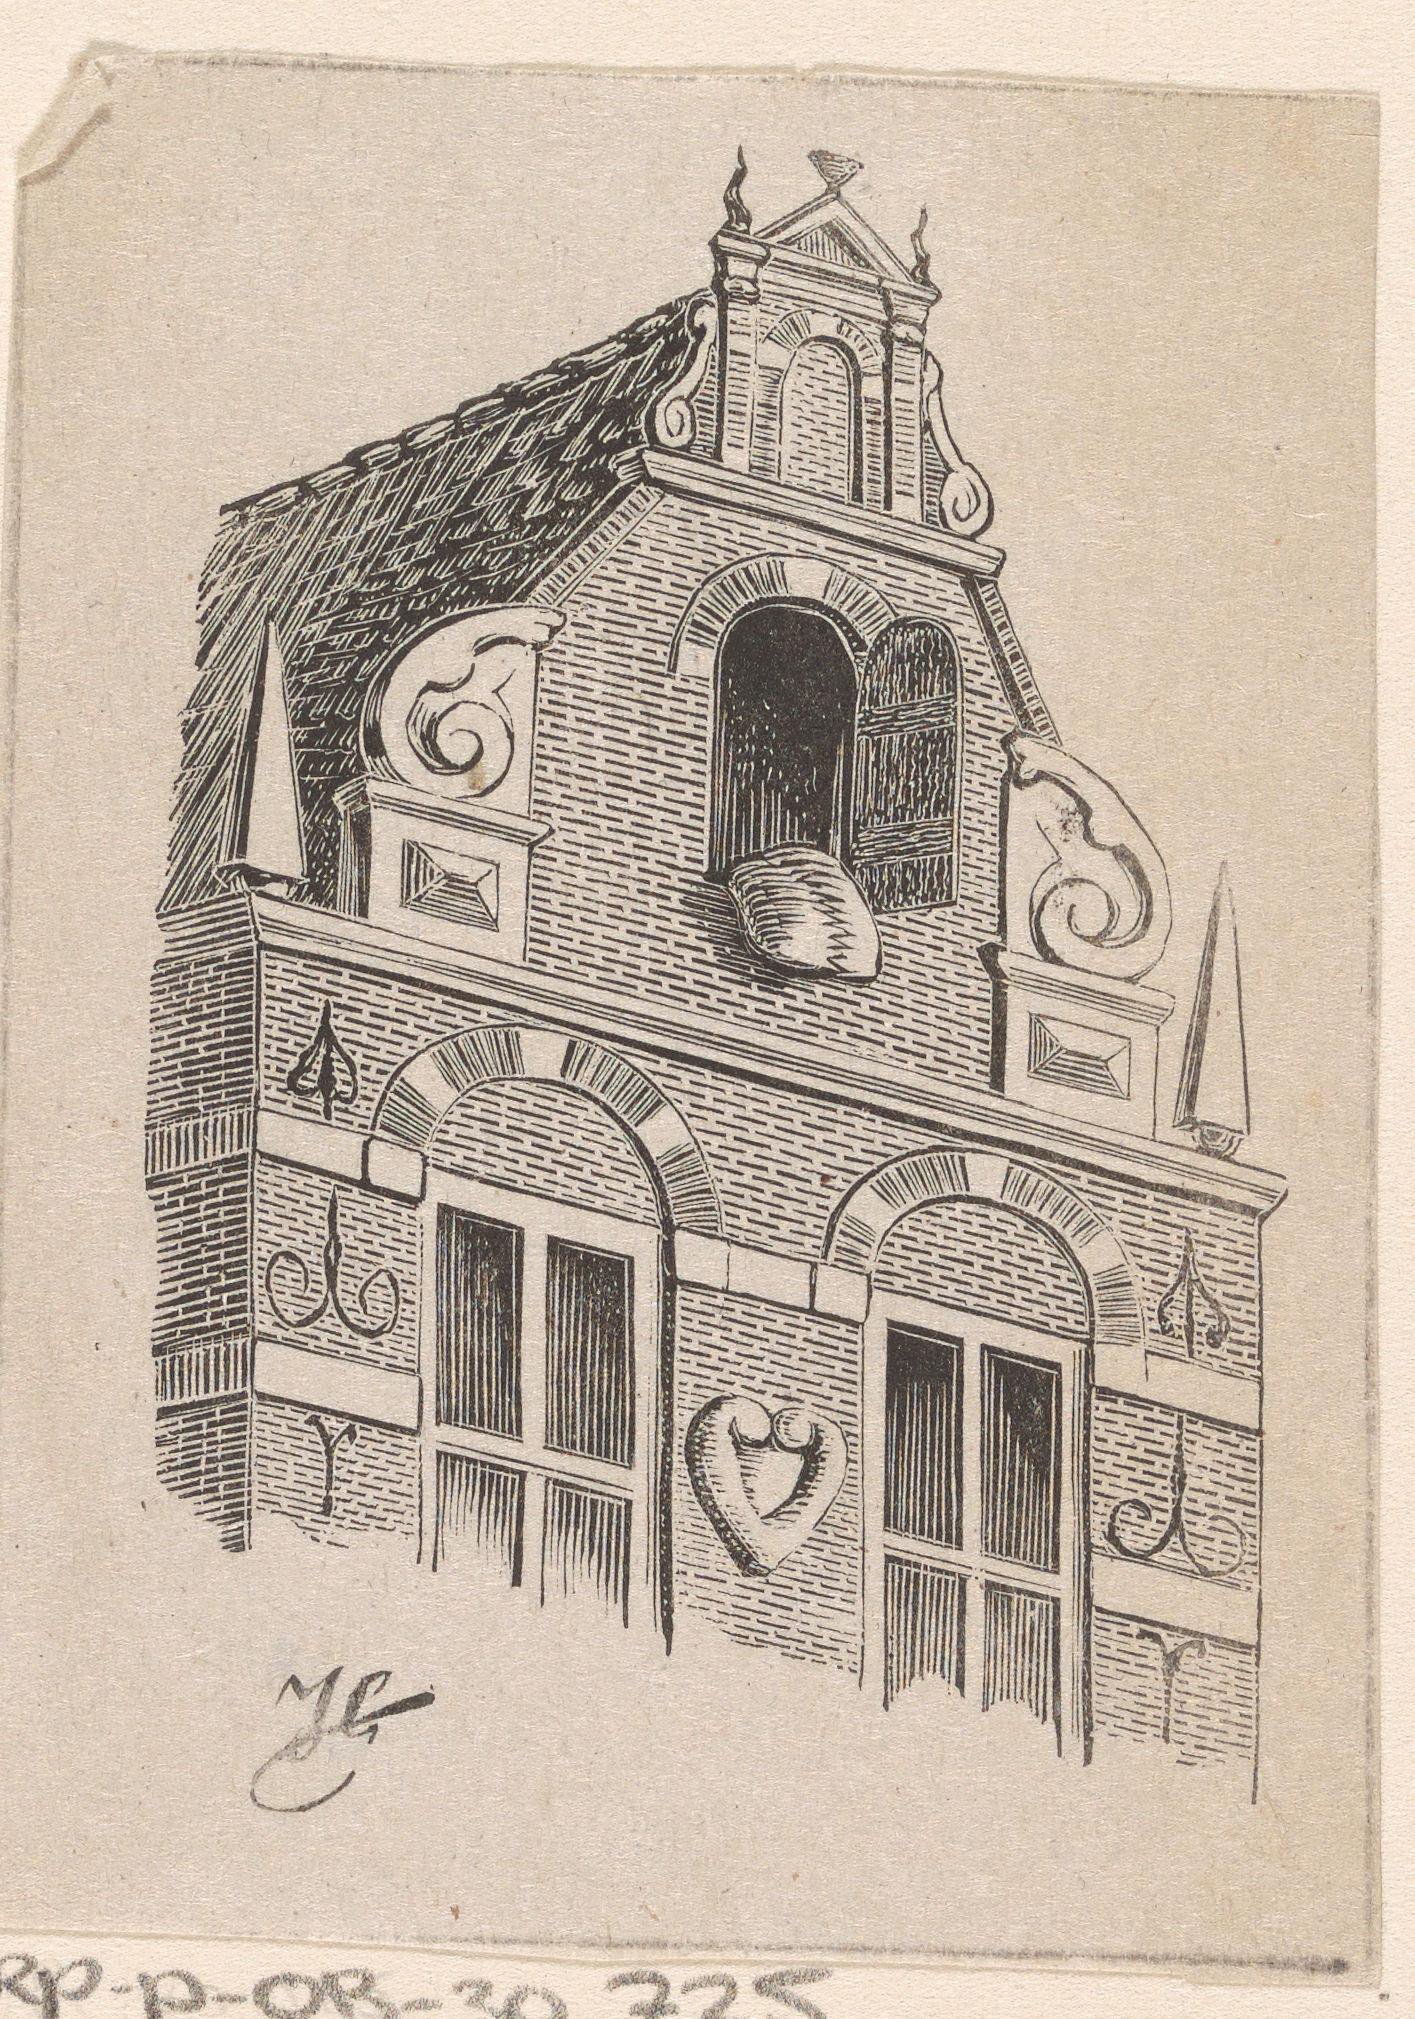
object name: print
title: Huis met beddengoed uit het venster hangend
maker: isaac weissenbruch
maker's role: print maker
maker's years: 1826-1912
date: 1836-1912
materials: paper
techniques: engraving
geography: netherlands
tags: bedding, civic architecture; edifices; dwellings